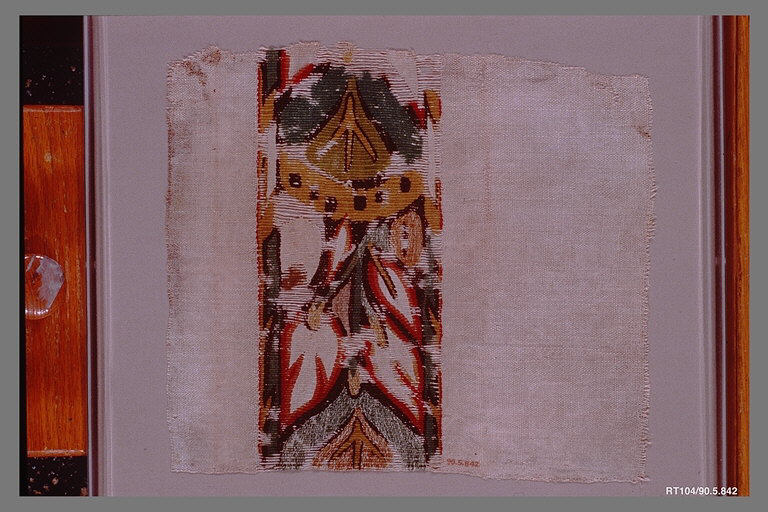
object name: band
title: Fragment with a Lotus Band Motif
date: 401-600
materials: linen, wool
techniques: weave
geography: egypt